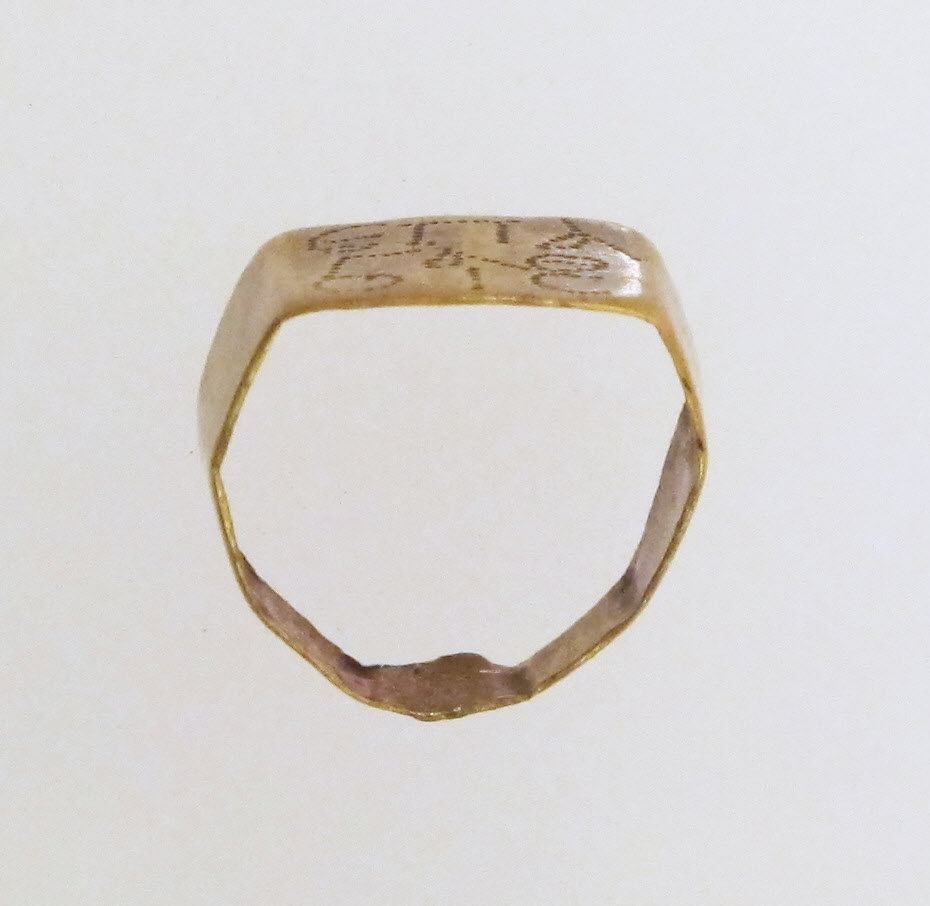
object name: ring, motto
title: Gold ring with inscribed bezel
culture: roman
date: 101-300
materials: gold